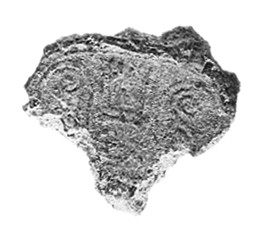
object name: sealing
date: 1981-1640 BCE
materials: mud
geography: egypt